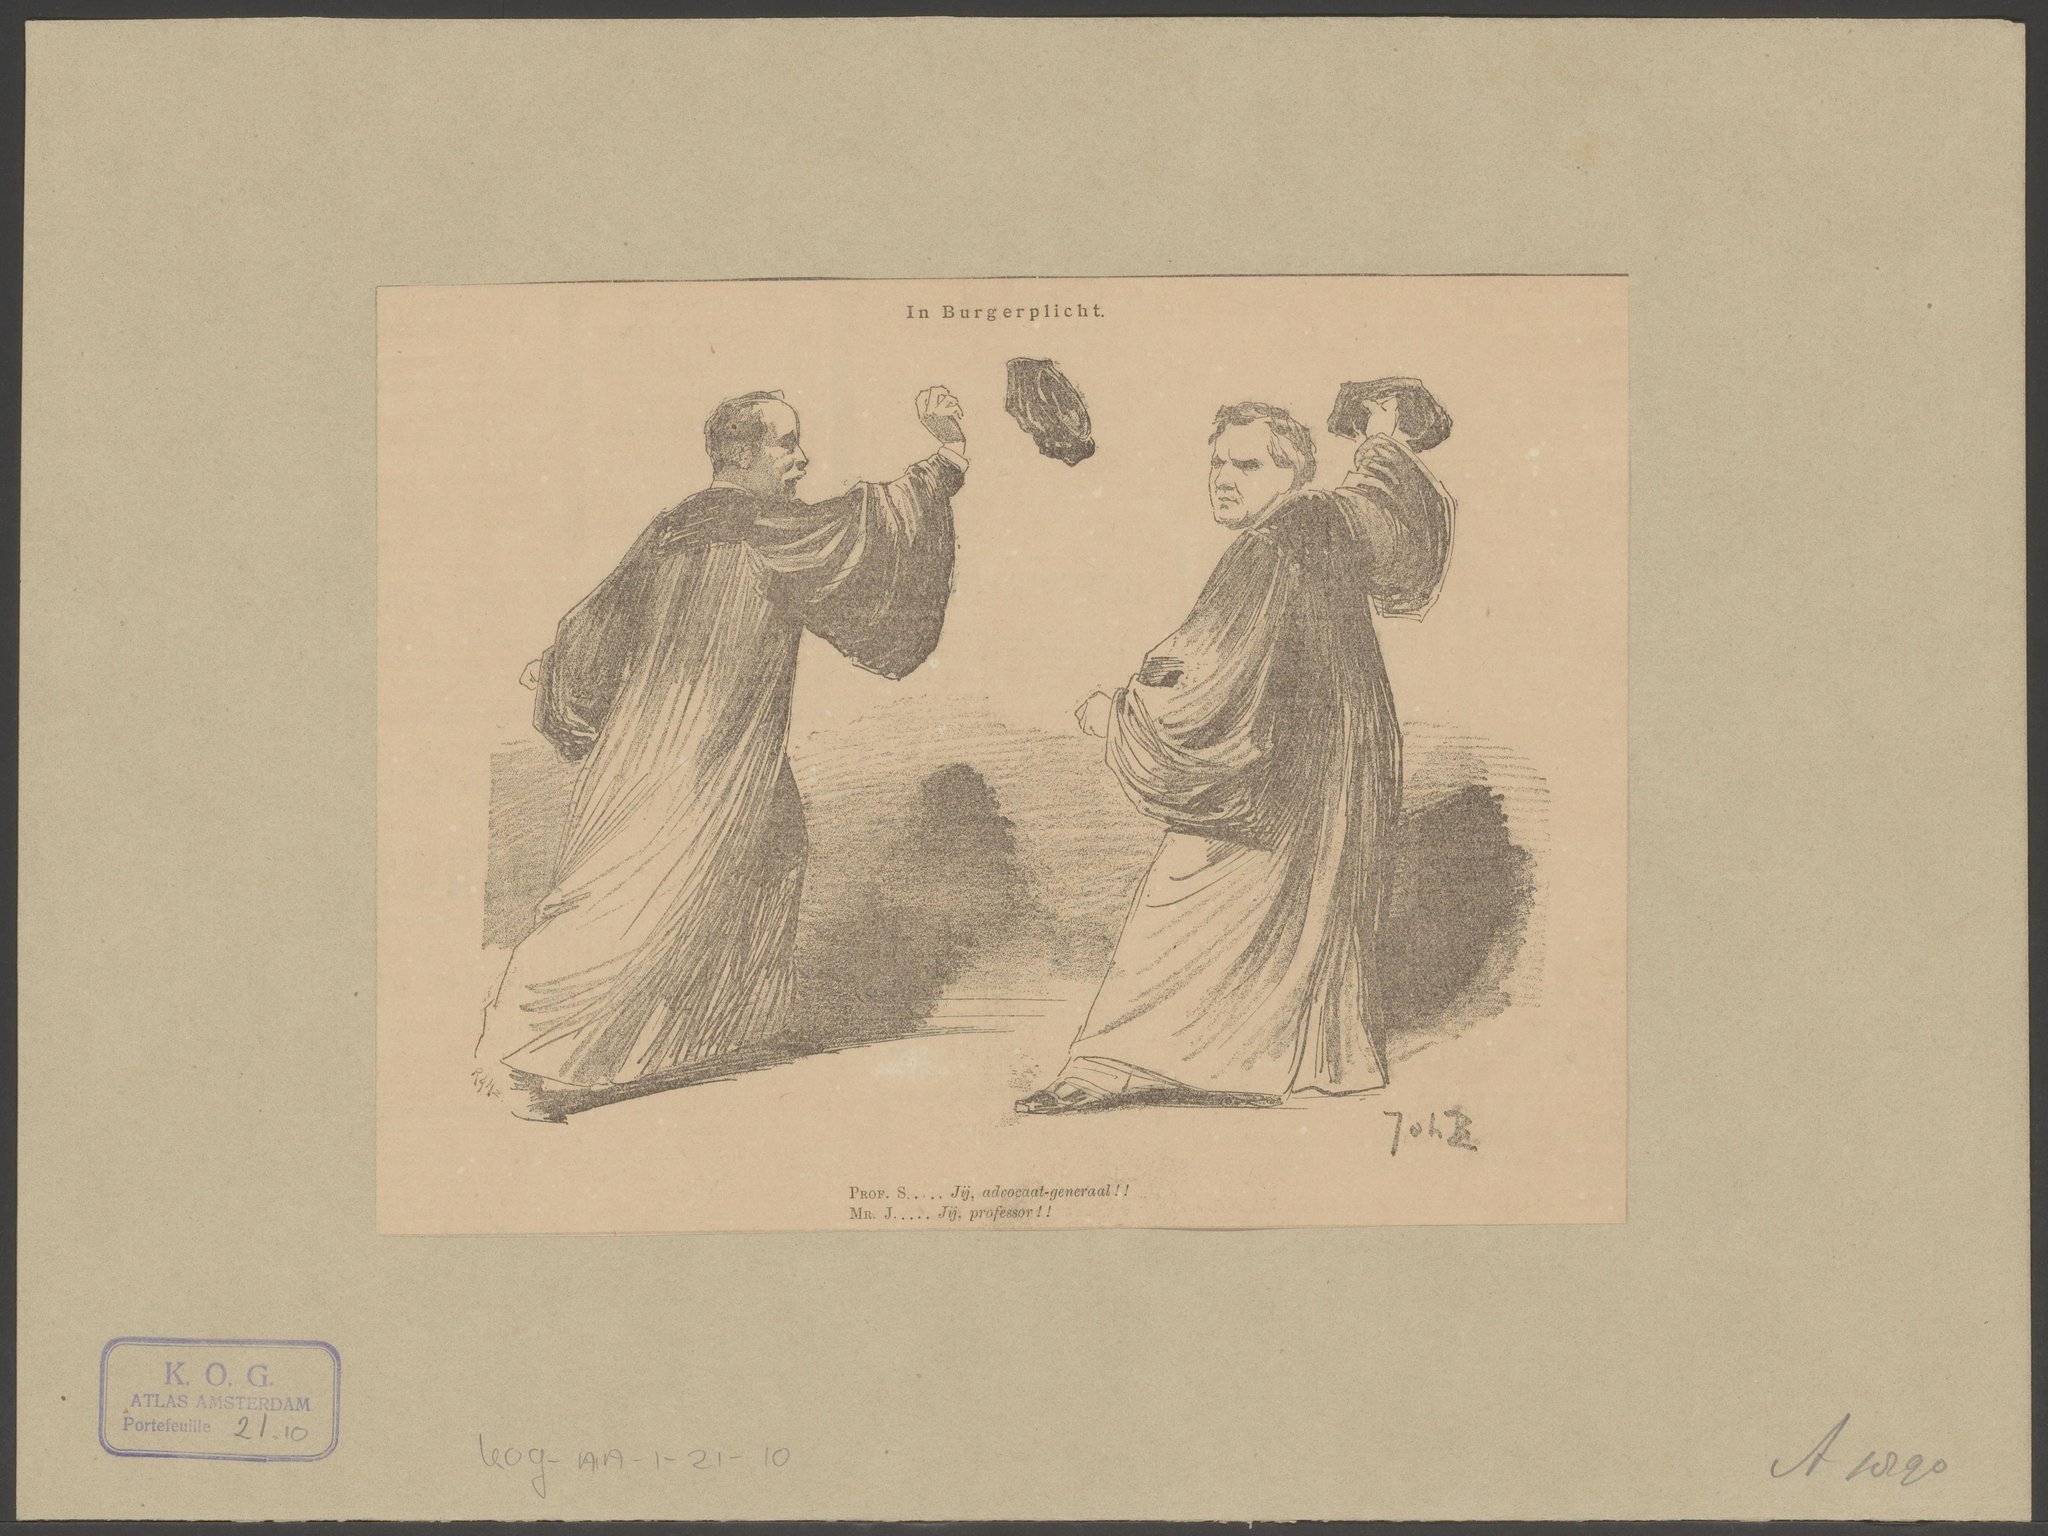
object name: photomechanical print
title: In Burgerplicht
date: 1891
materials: paper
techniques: letterpress printing, line block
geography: netherlands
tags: politician, e.g. party leader, political caricatures and satires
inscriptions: collector's mark: Lugt 1641b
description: Onderwerpsrubriek binnen de Atlas Amsterdam: Kiesverenigingen, Politieke partijen.